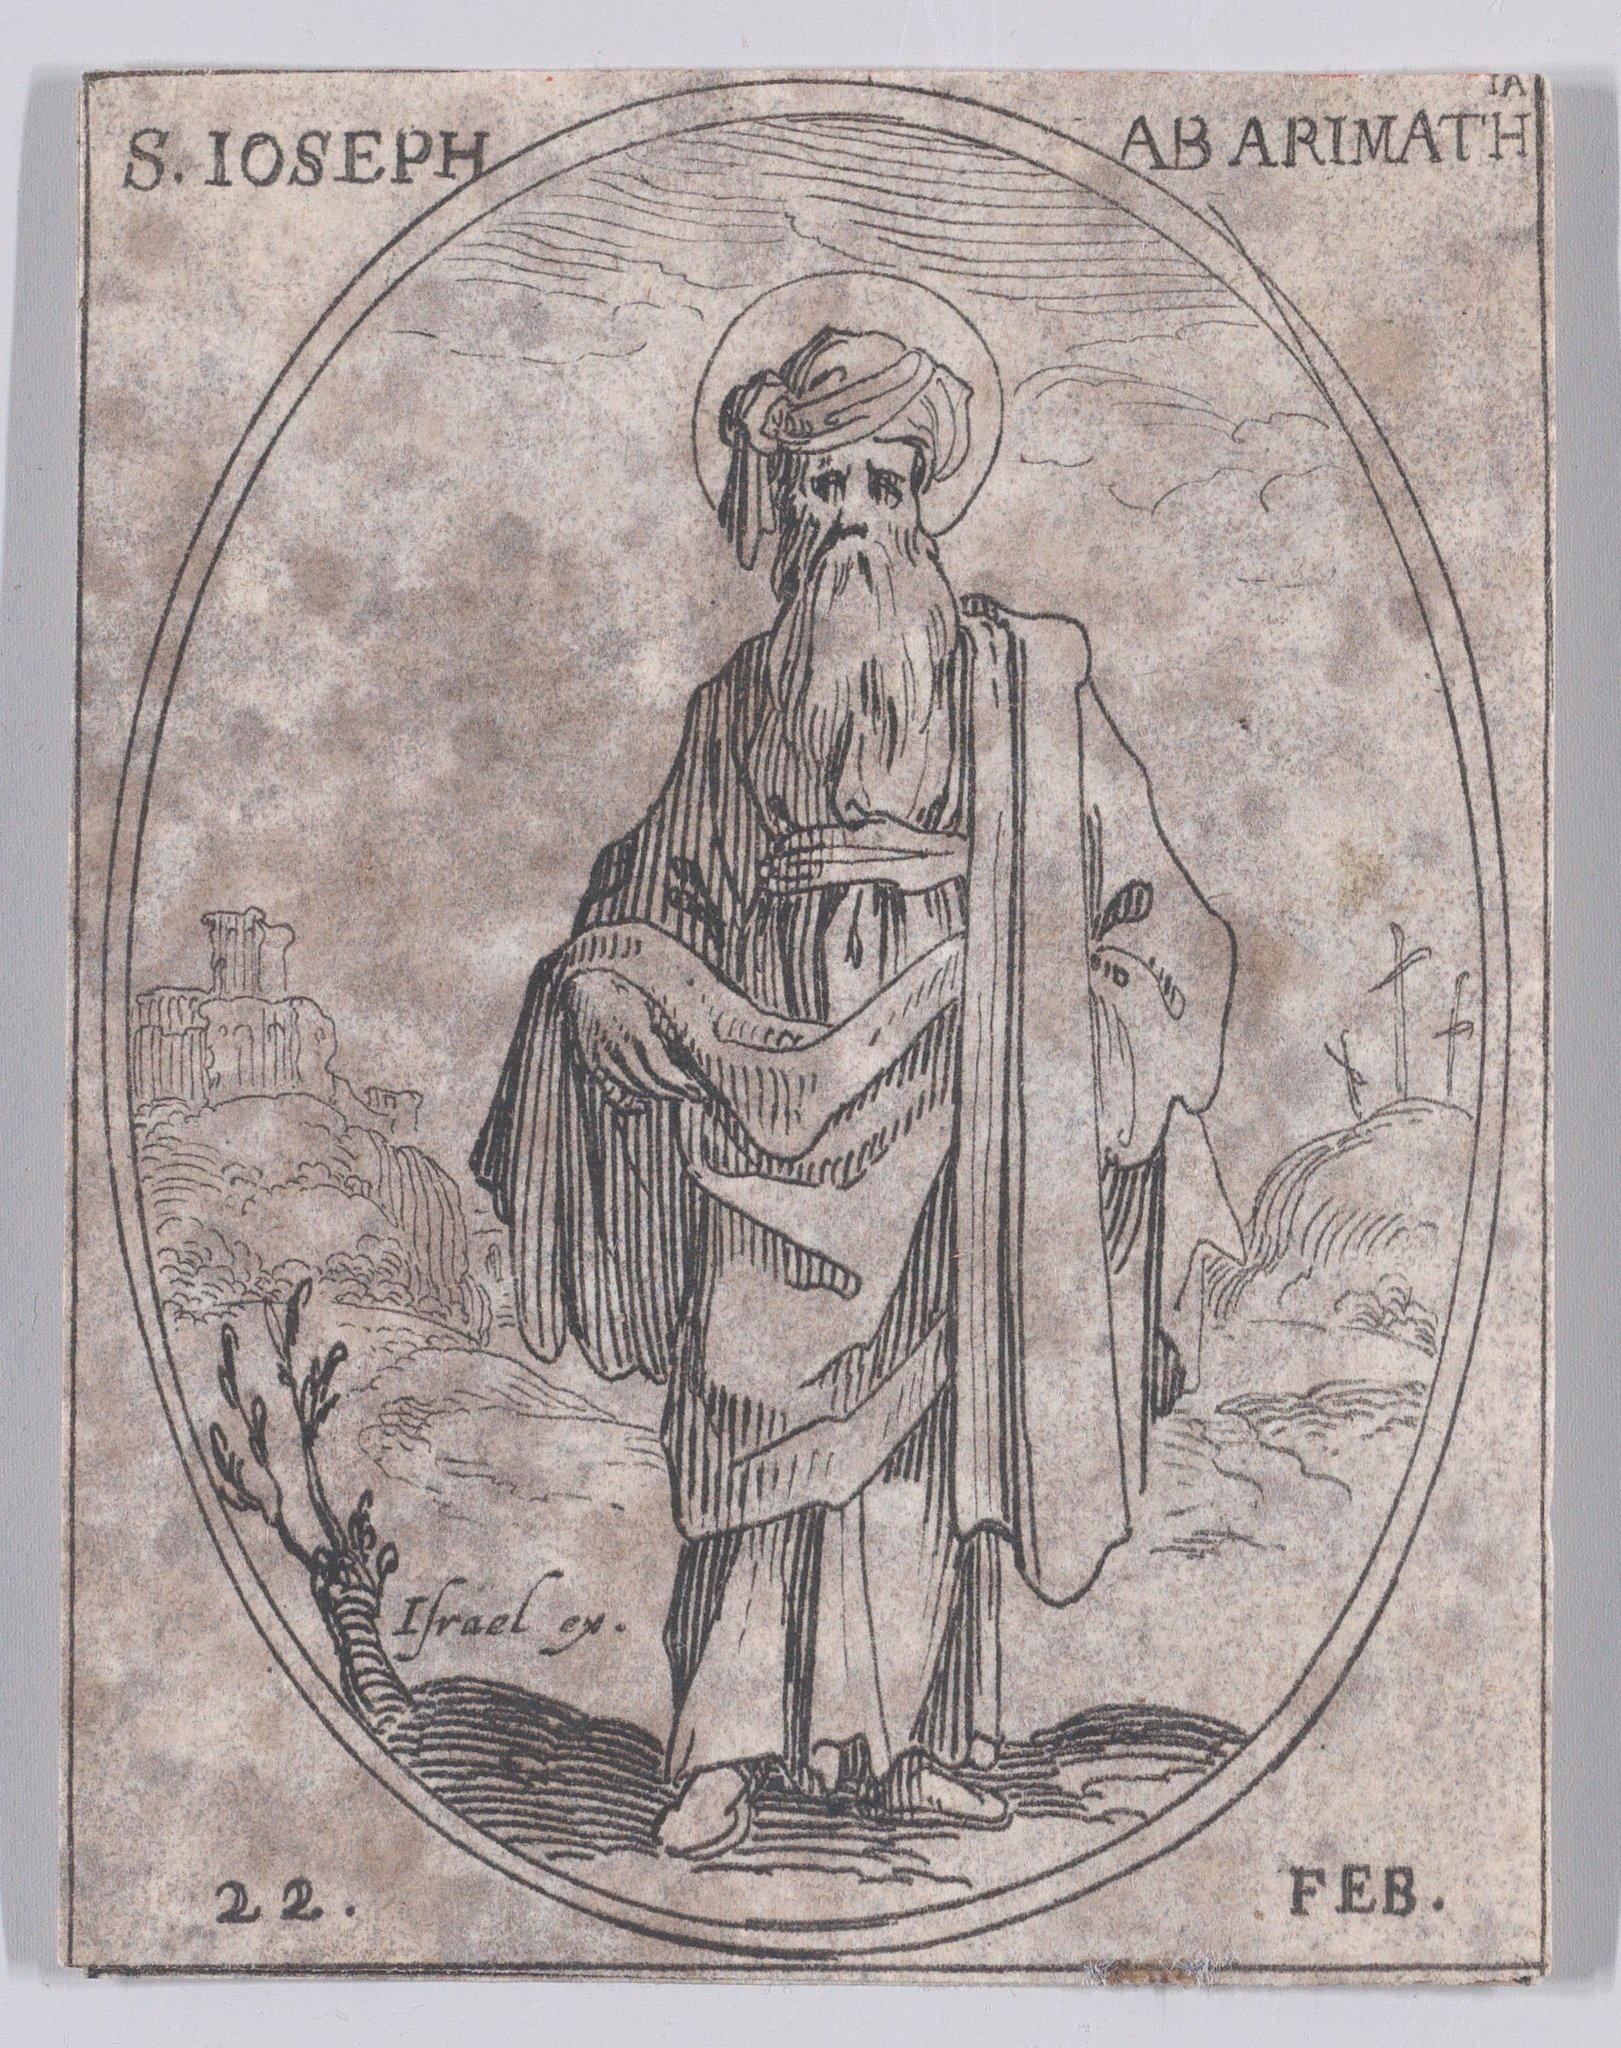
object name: print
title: S. Félix, évêque de Metz (St. Felix, Bishop of Metz), February 21st, from "Les Images De Tous Les Saincts et Saintes de L'Année" (Images of All of the Saints and Religious Events of the Year)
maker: jacques callot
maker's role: artist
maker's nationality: french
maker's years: 1592-1635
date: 1636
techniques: etching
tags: men,saints